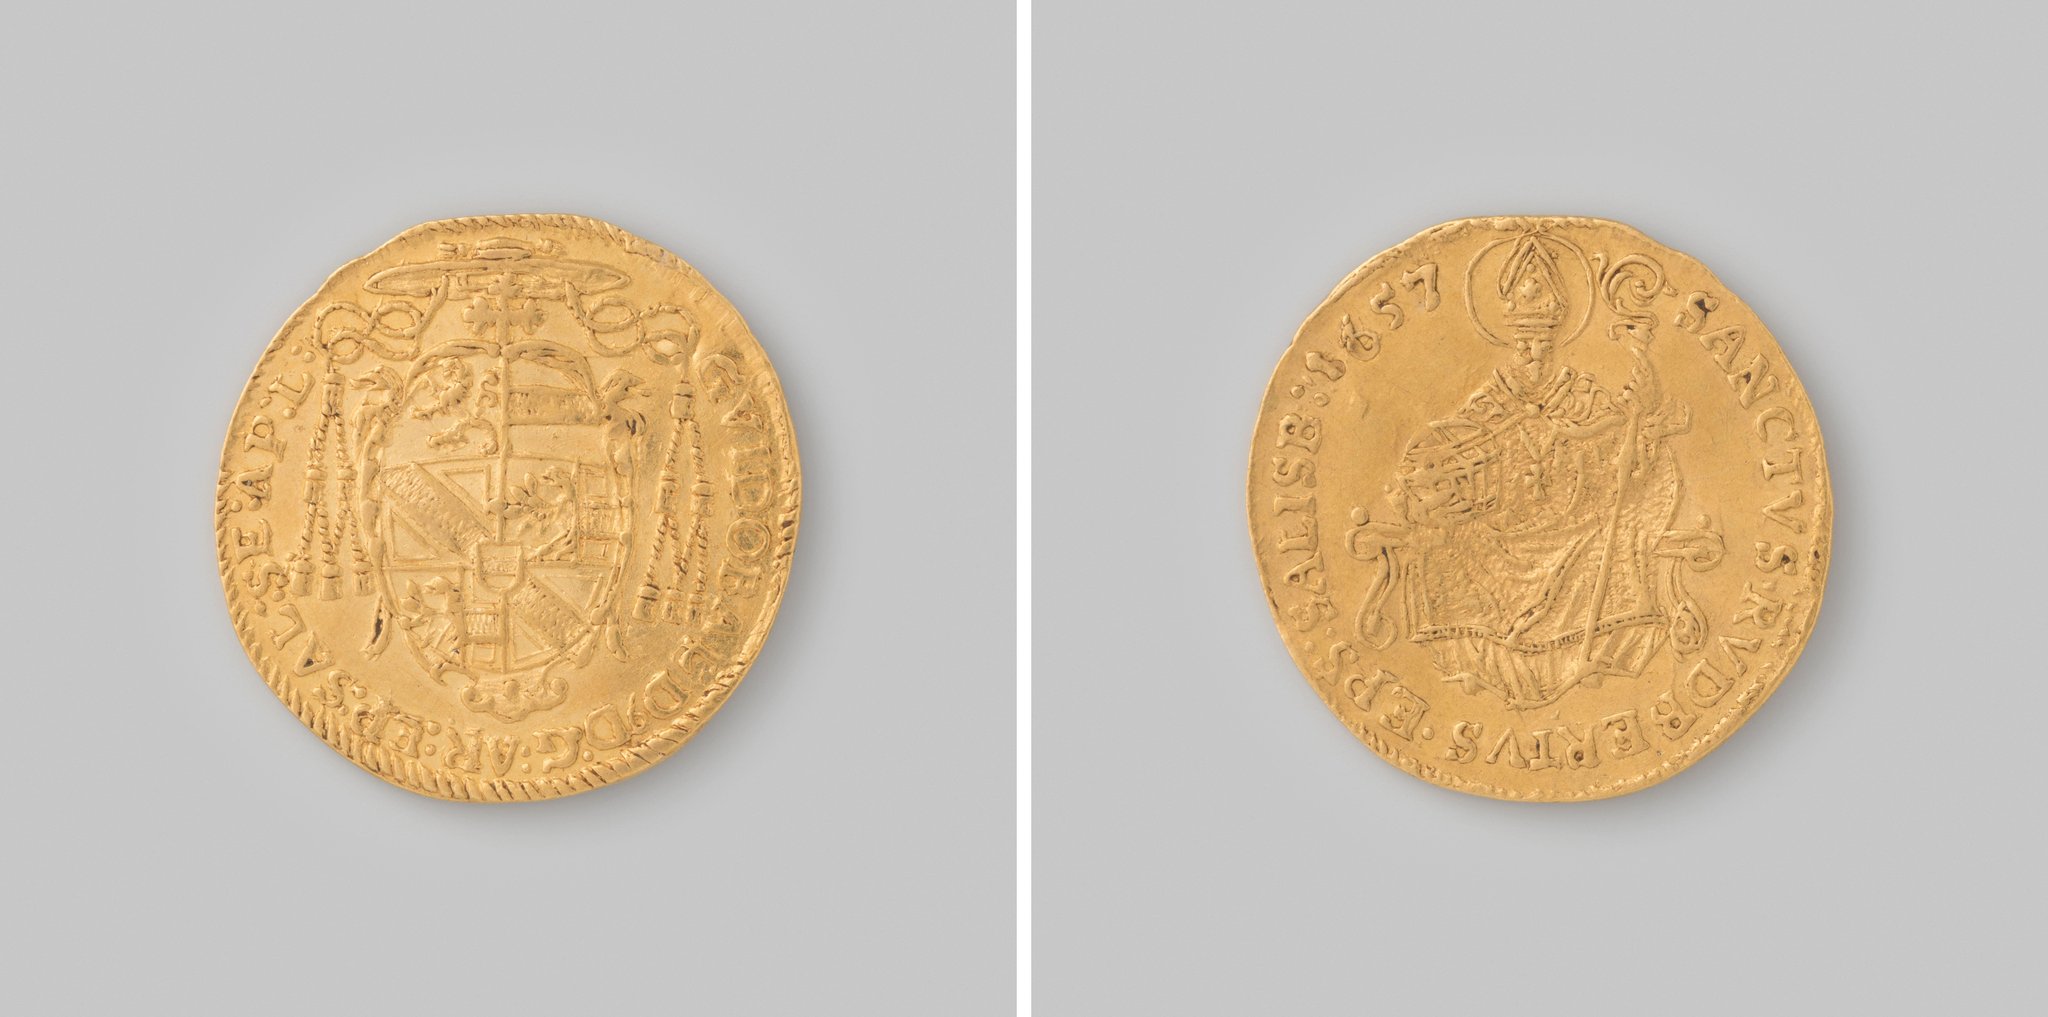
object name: ducat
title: Dukaat uit het aartsbisdom Salzburg van Guidobald von Thun,1657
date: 1657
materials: gold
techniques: striking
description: Gouden munt. Voorzijde: versierd wapenschild, waarboven kruis met de hoed van de aarstbisschop. Keerzijde: zittende bisschop met mijter en staf. Jaartal aan het eind van het omschrift.